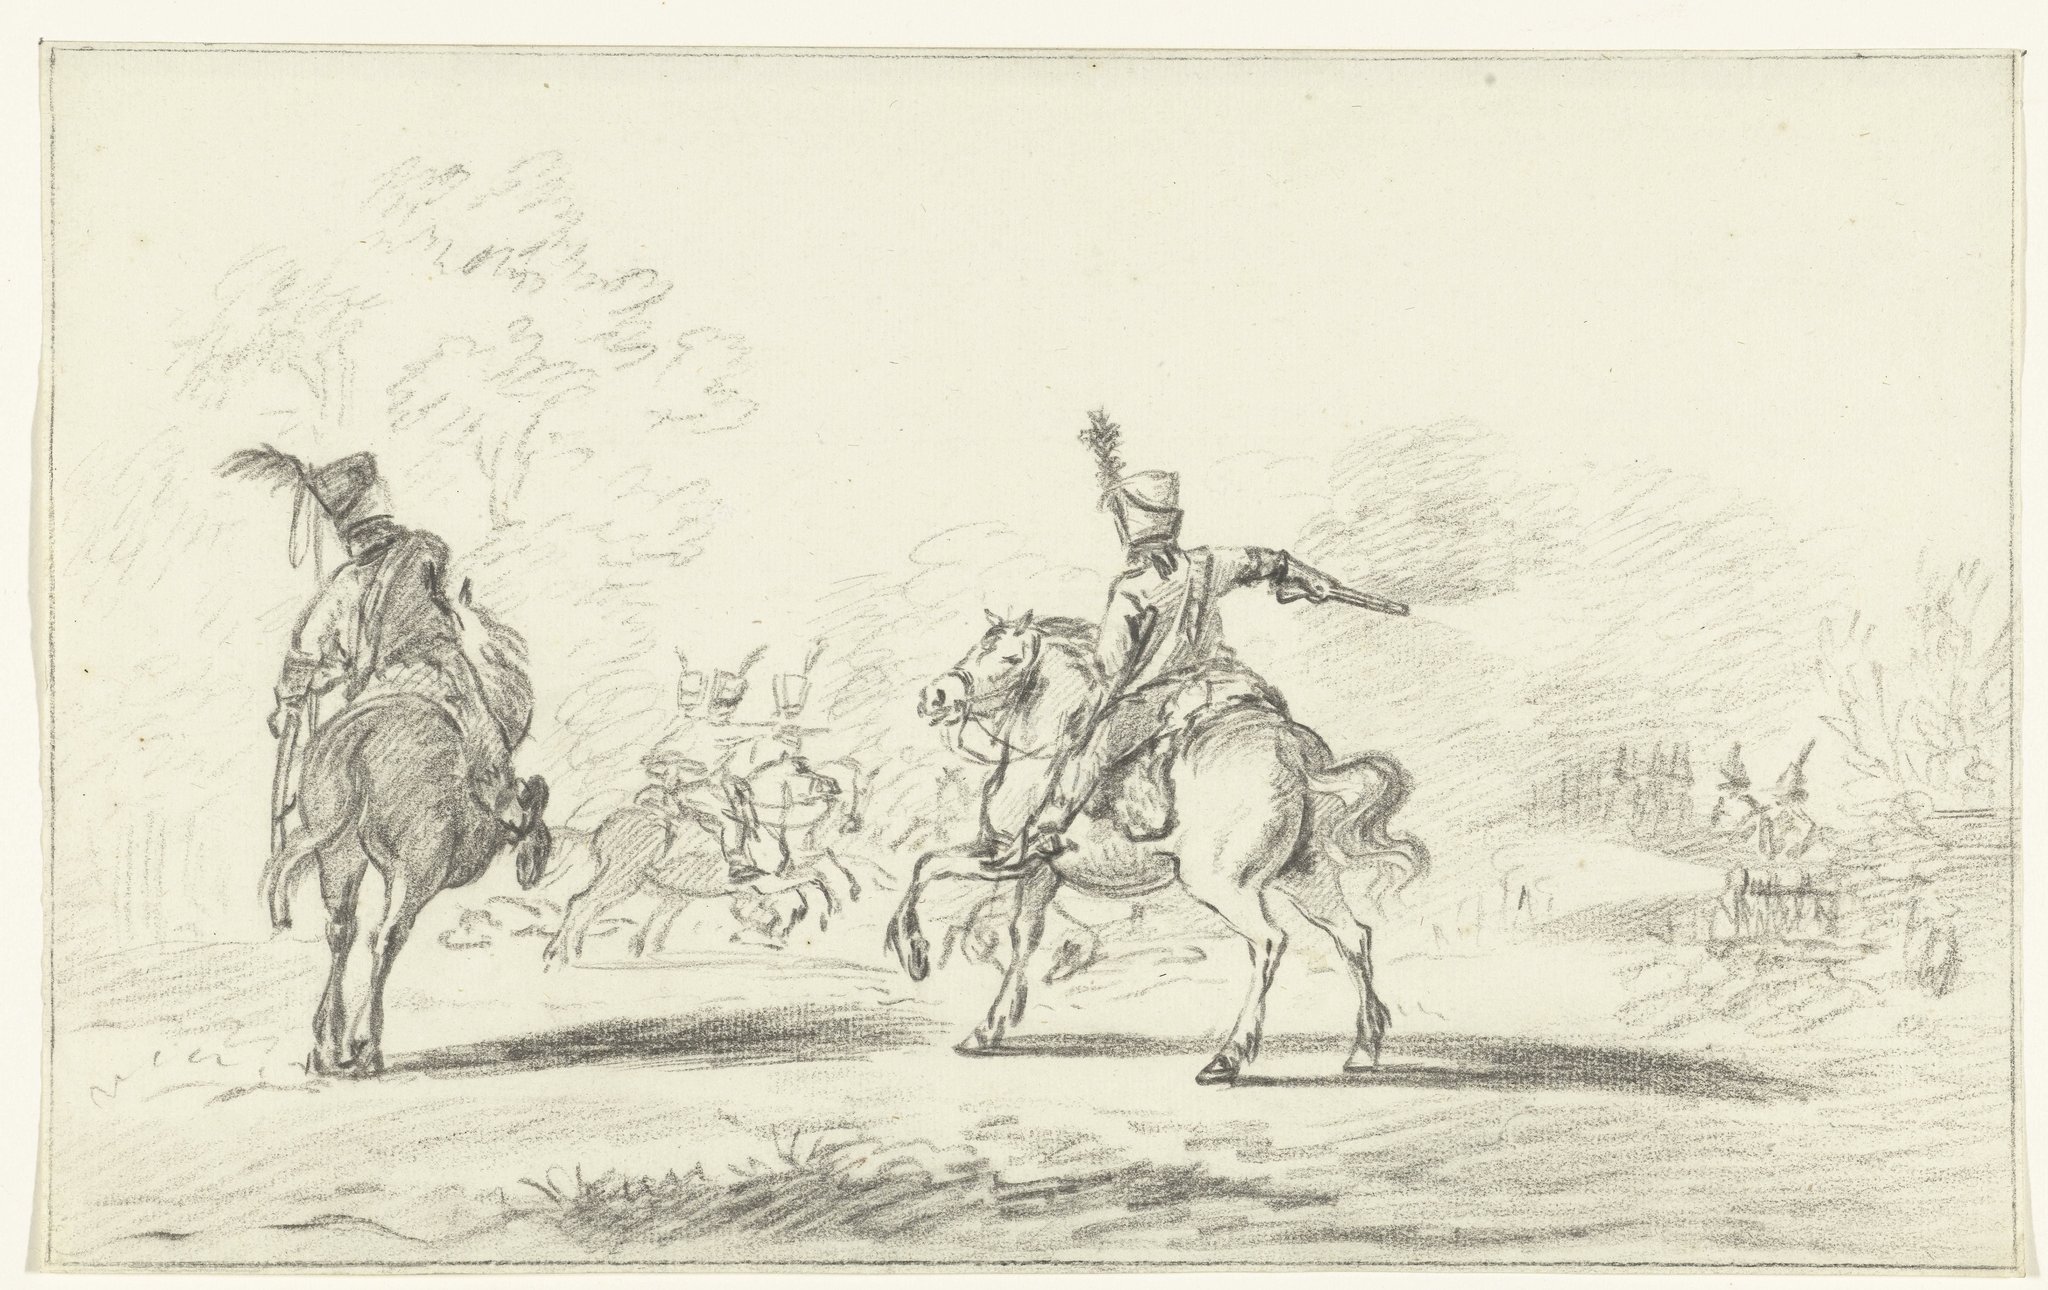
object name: drawing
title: Cavalerie-gevecht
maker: jean bernard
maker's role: draughtsman, print maker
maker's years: 1765-1833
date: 1775-1833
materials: chalk, paper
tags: battle (+ cavalry, horsemen), horse